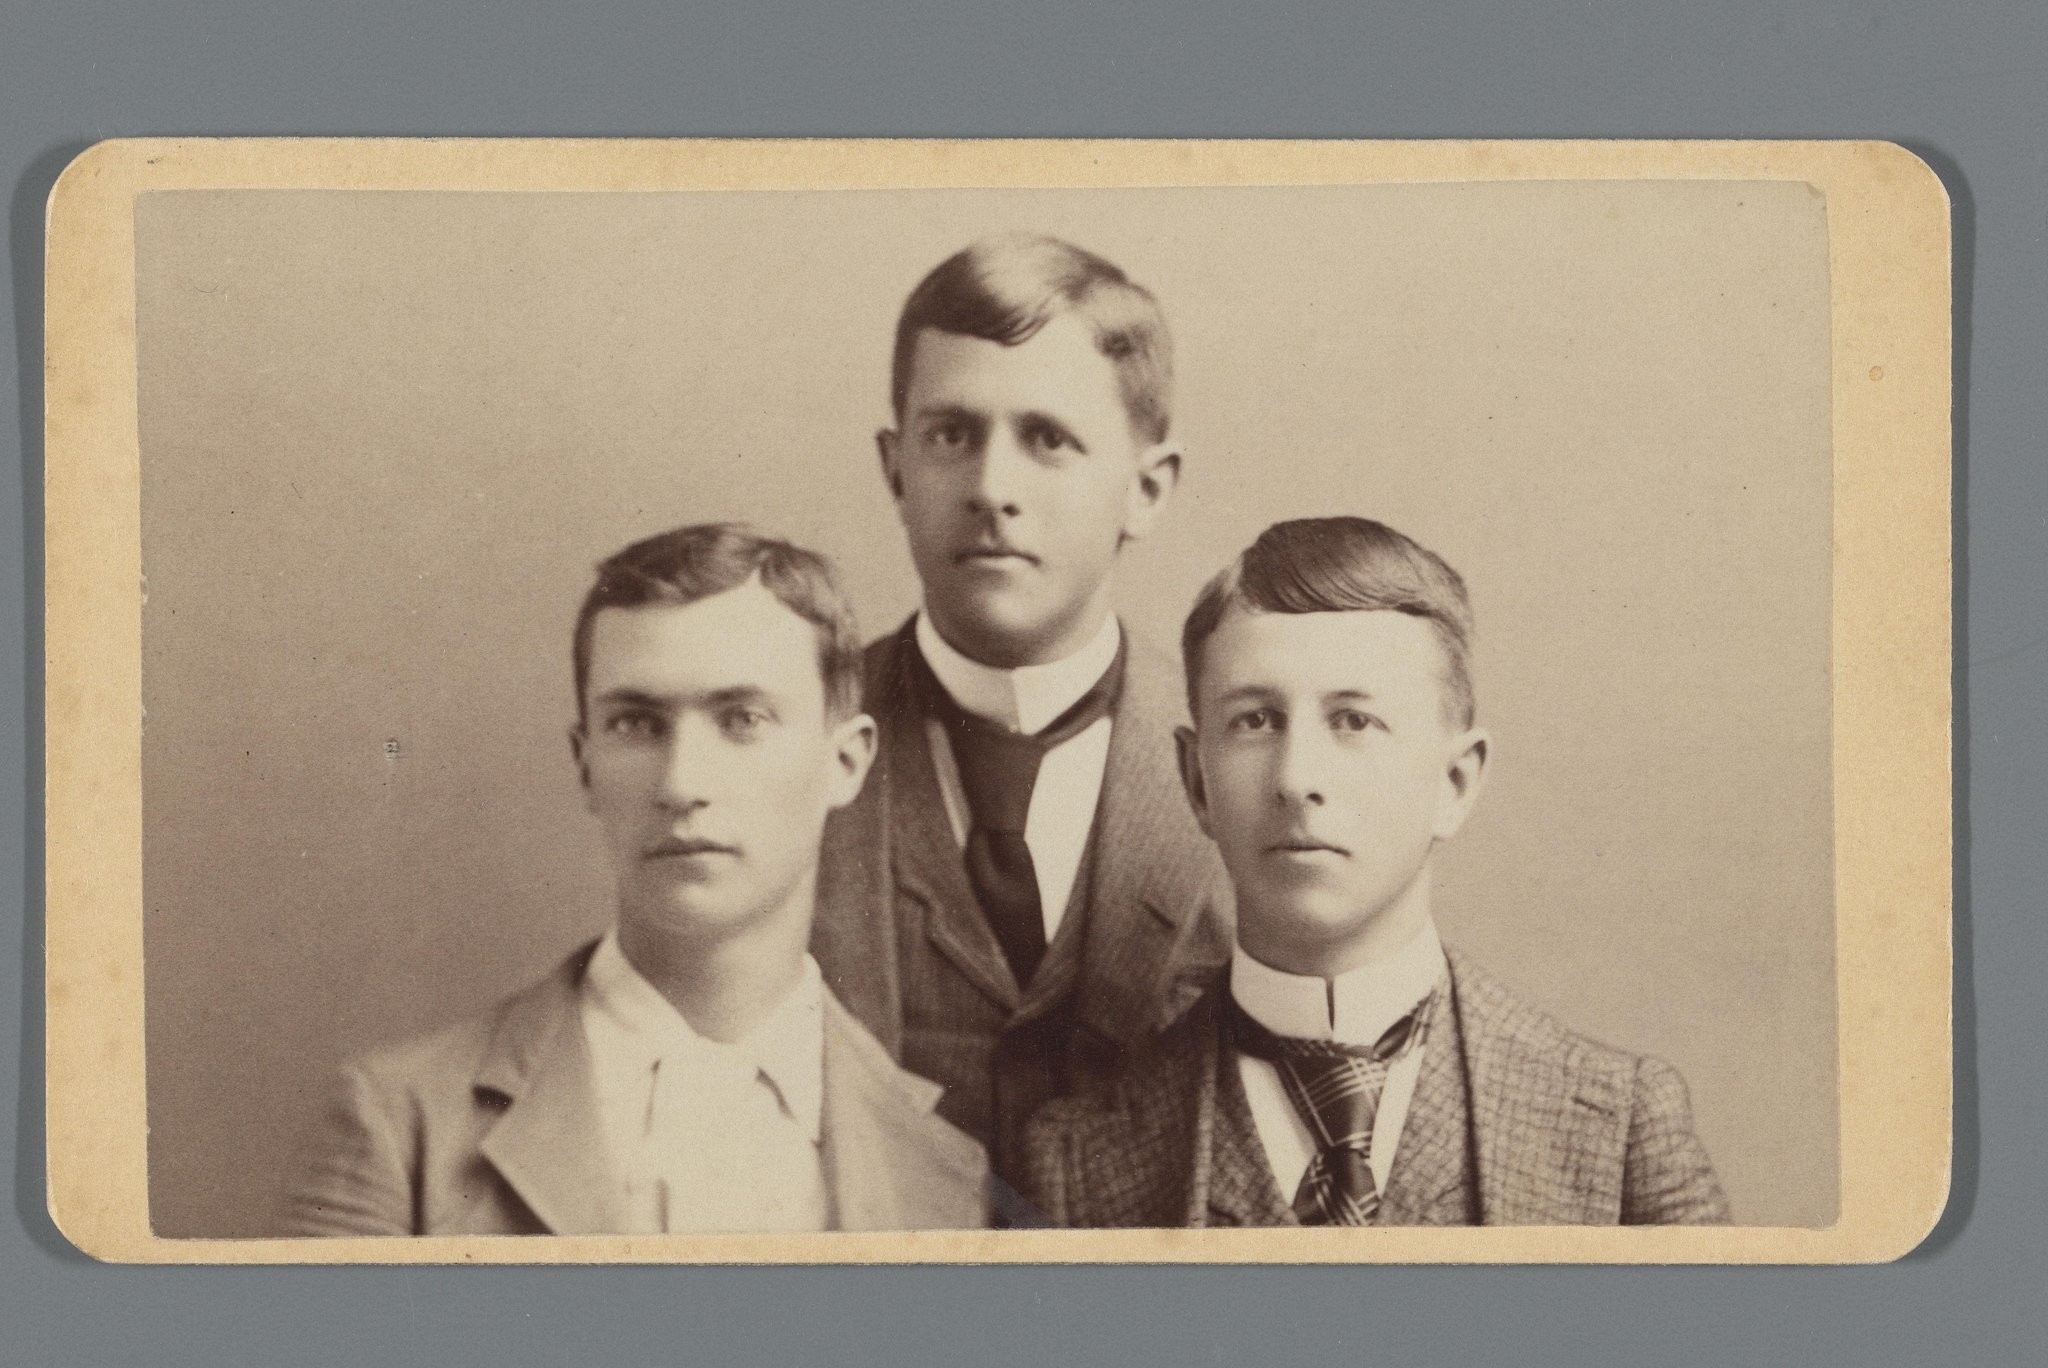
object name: photograph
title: Drie mannen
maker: o. elliott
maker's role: fotograaf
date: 1870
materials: cardboard, photographic support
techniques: albumen print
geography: stockton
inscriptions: inscription, inscription